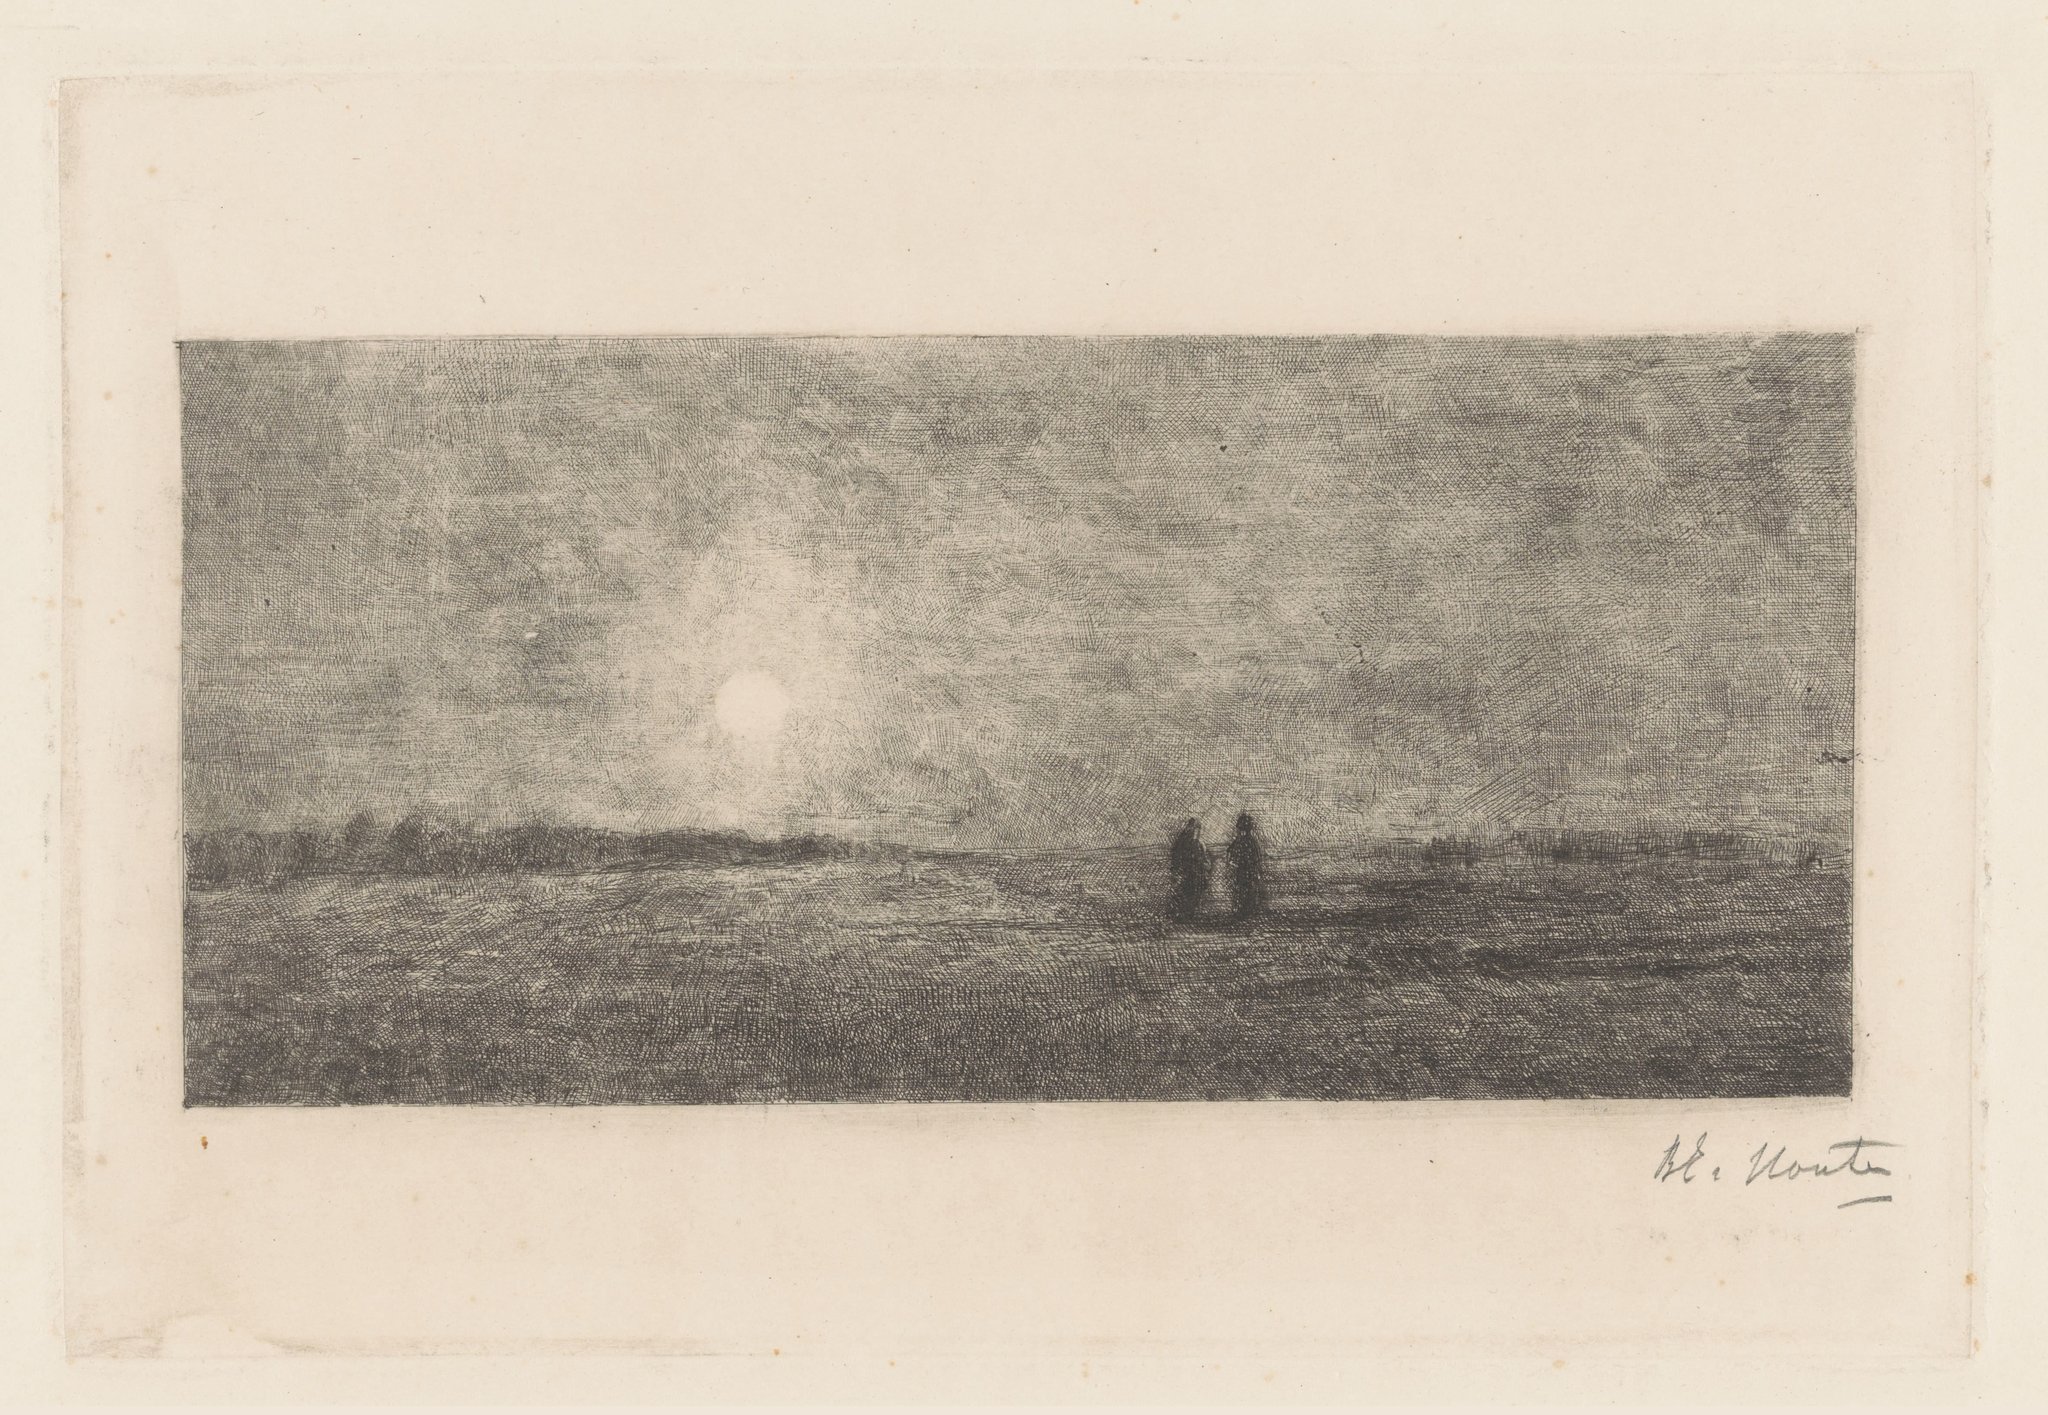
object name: print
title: Landschap met zon en twee figuren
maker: barbara elisabeth van houten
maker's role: draughtsman, print maker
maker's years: 1862-1950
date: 1877-1950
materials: paper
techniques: etching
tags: plain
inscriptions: collector's mark: Lugt 2228